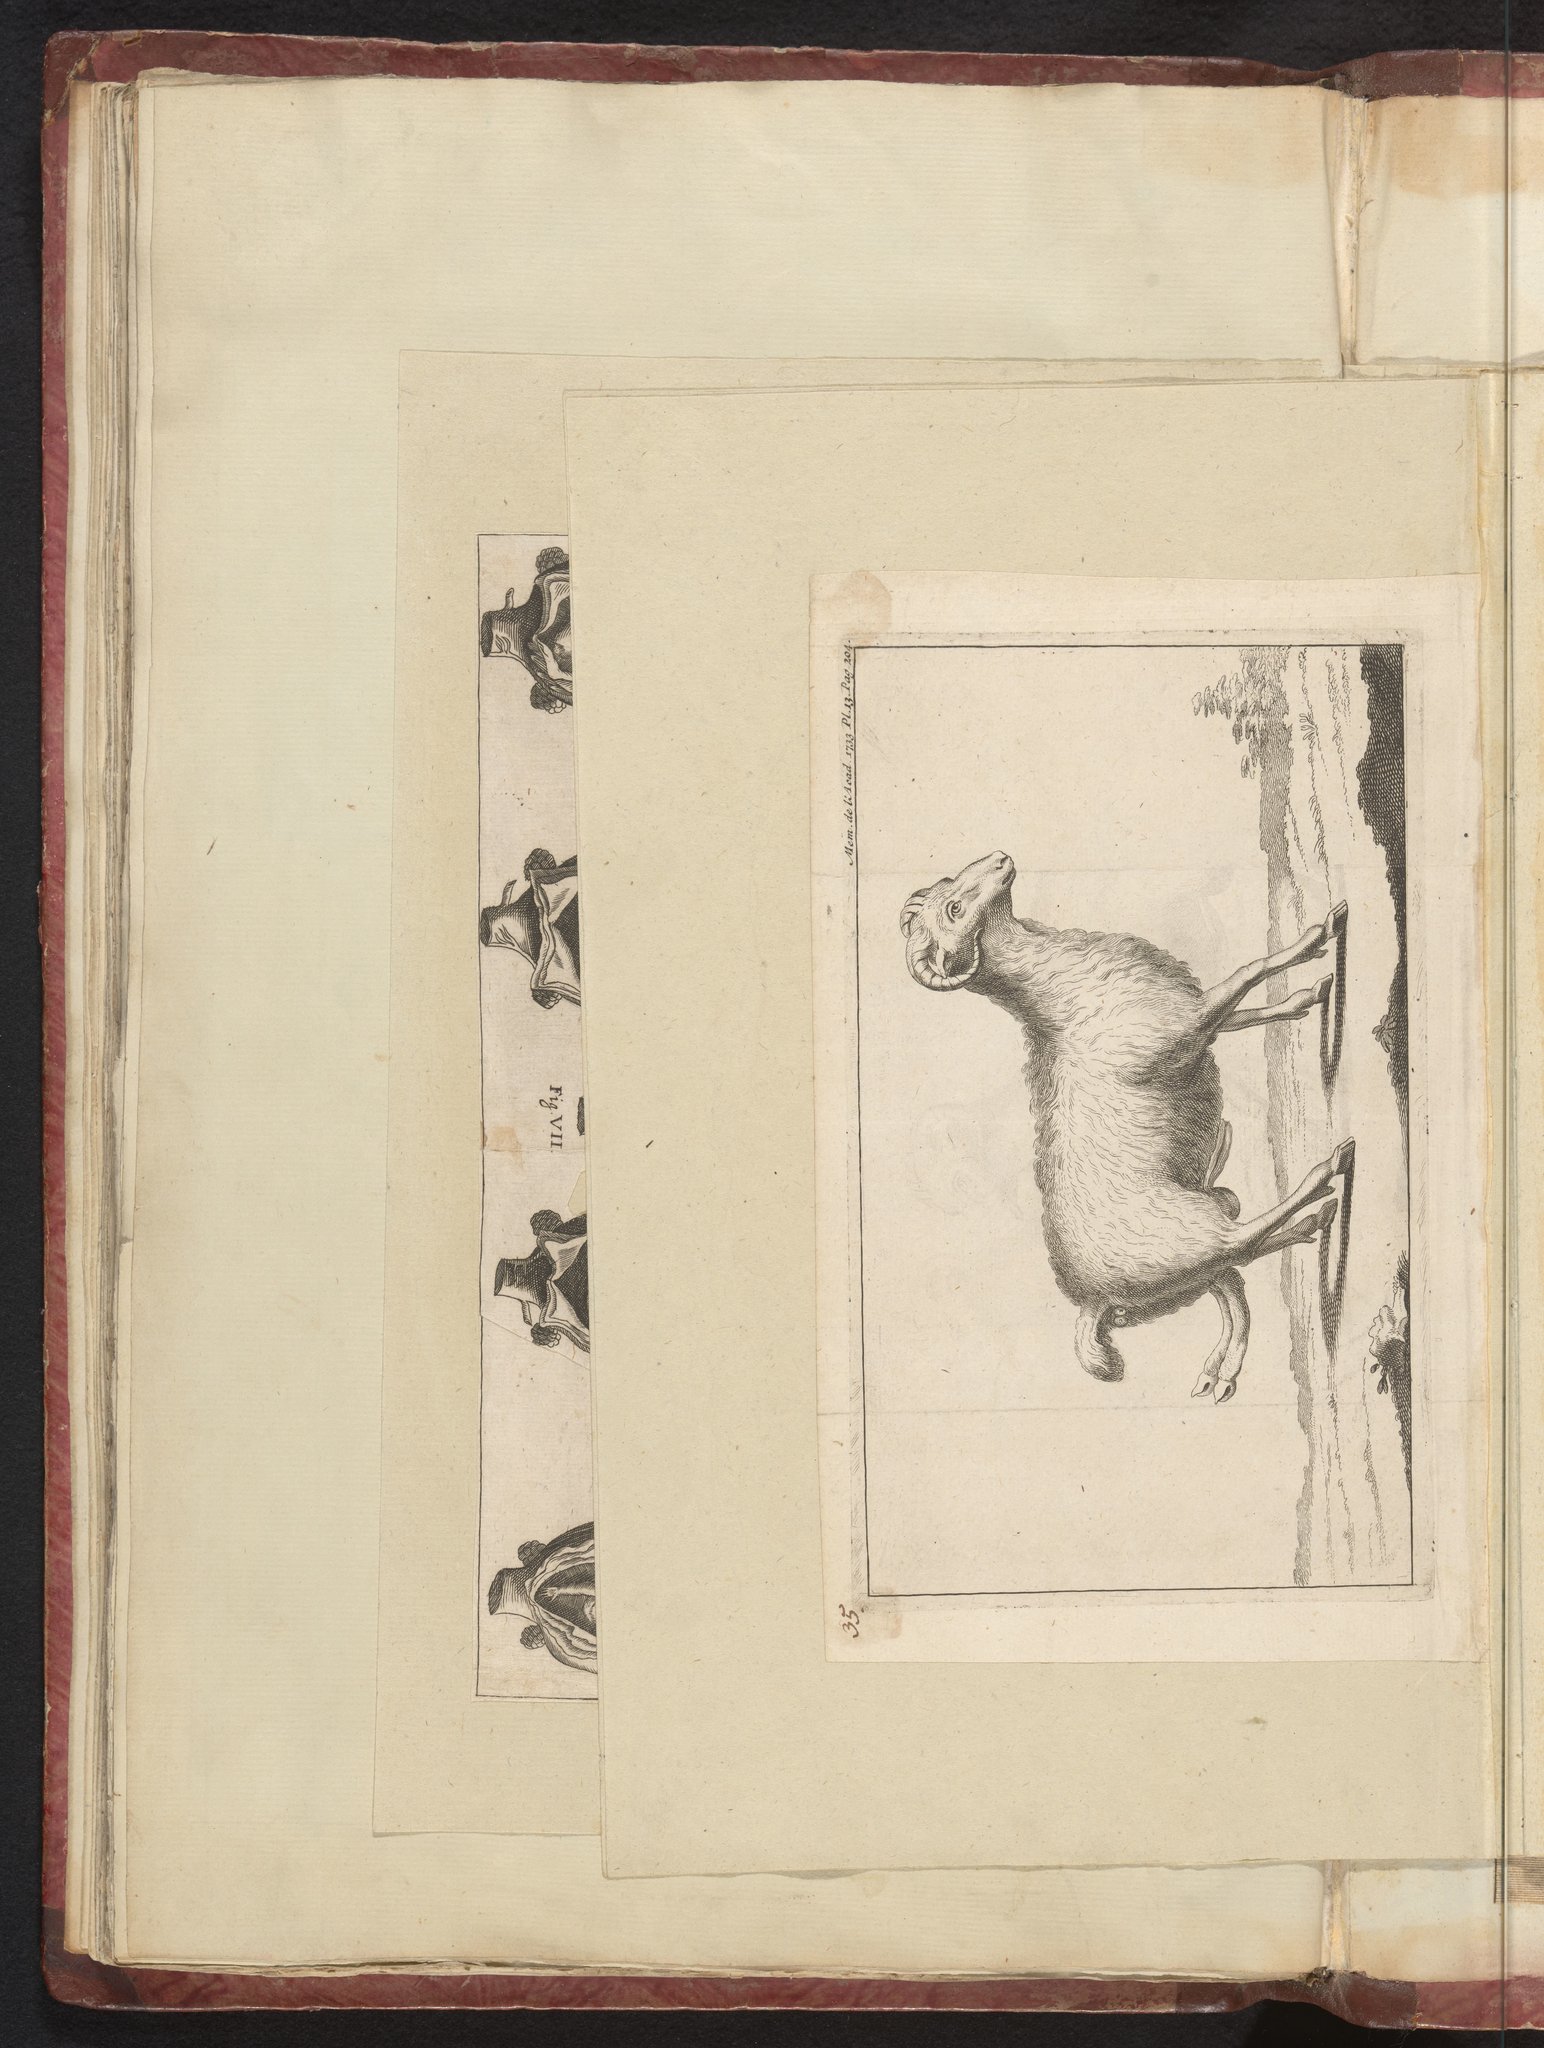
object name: print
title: Schaap met zes poten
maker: Anonymous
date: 1733-1735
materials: paper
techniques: engraving, etching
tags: monsters with parts in greater number than normal, sheep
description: Ingeplakte prent van een schaap met zes poten. Linksboven genummerd: 35. Rechtsboven het jaartal 1733, pl. 13, pag. 204. Op een kleiner formaat blad papier. Onderdeel van het zevende album met tekeningen van reptielen, amfibieën en natuurhistorische ensembles. Het zevende van twaalf albums met aquarellen van dieren, vogels en planten bekend rond 1600, gemaakt in opdracht van keizer Rudolf II. Met toelichting in Nederlands, Latijn en Frans.